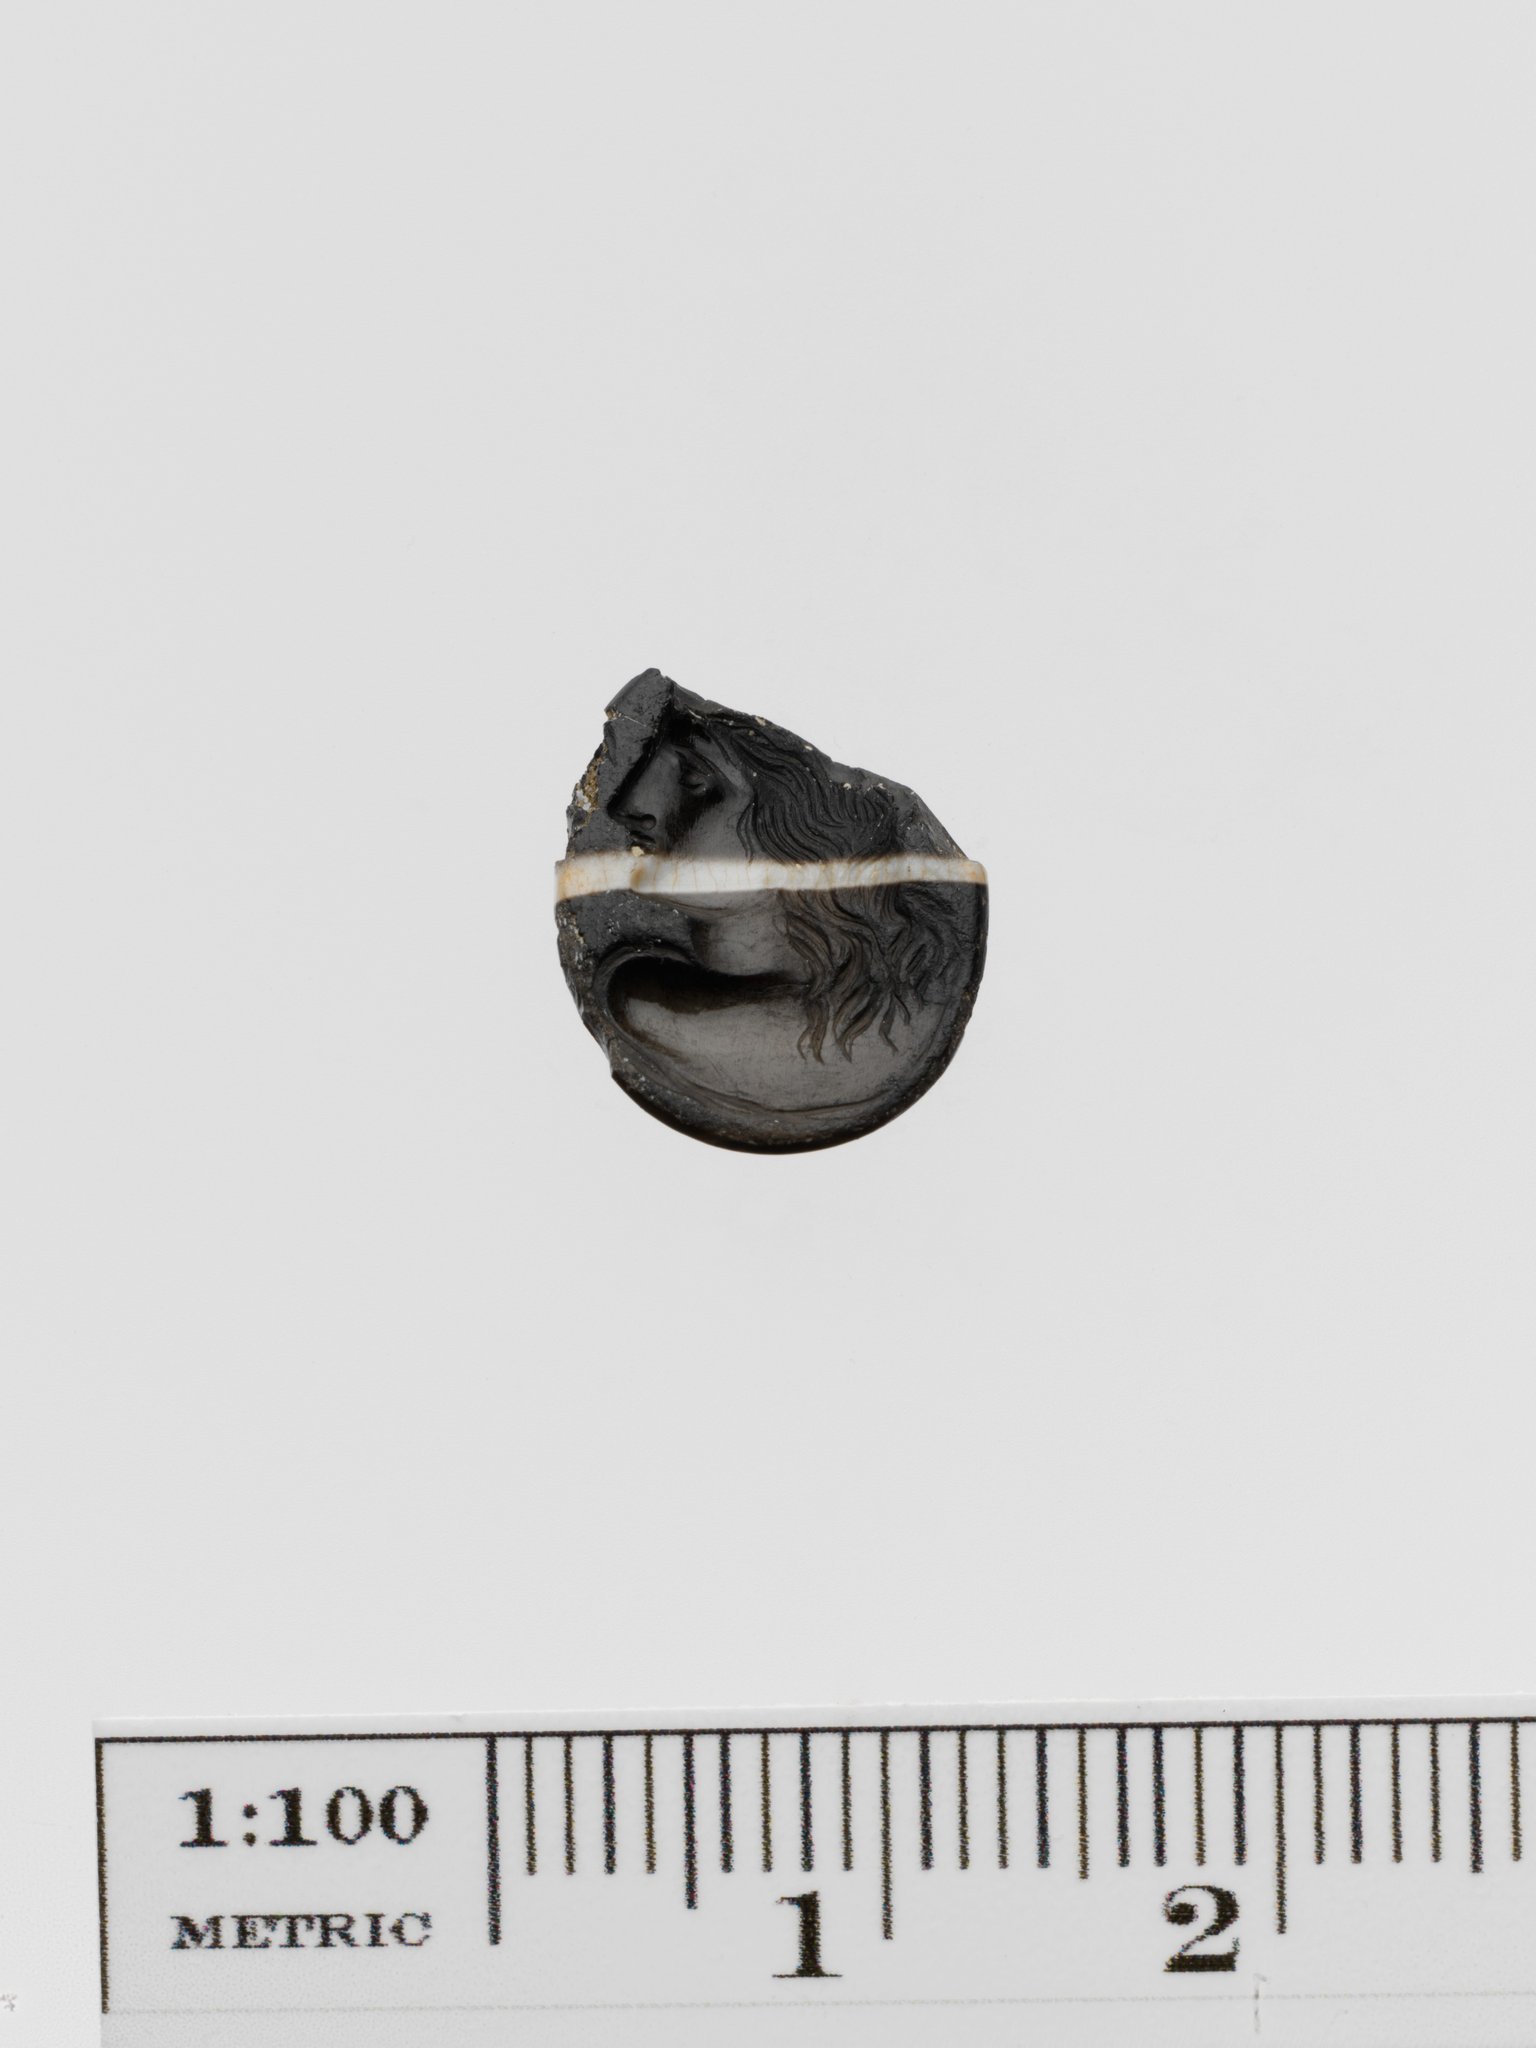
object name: intaglio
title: Agate ring stone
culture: greek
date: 300-201 BCE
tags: heads,profiles